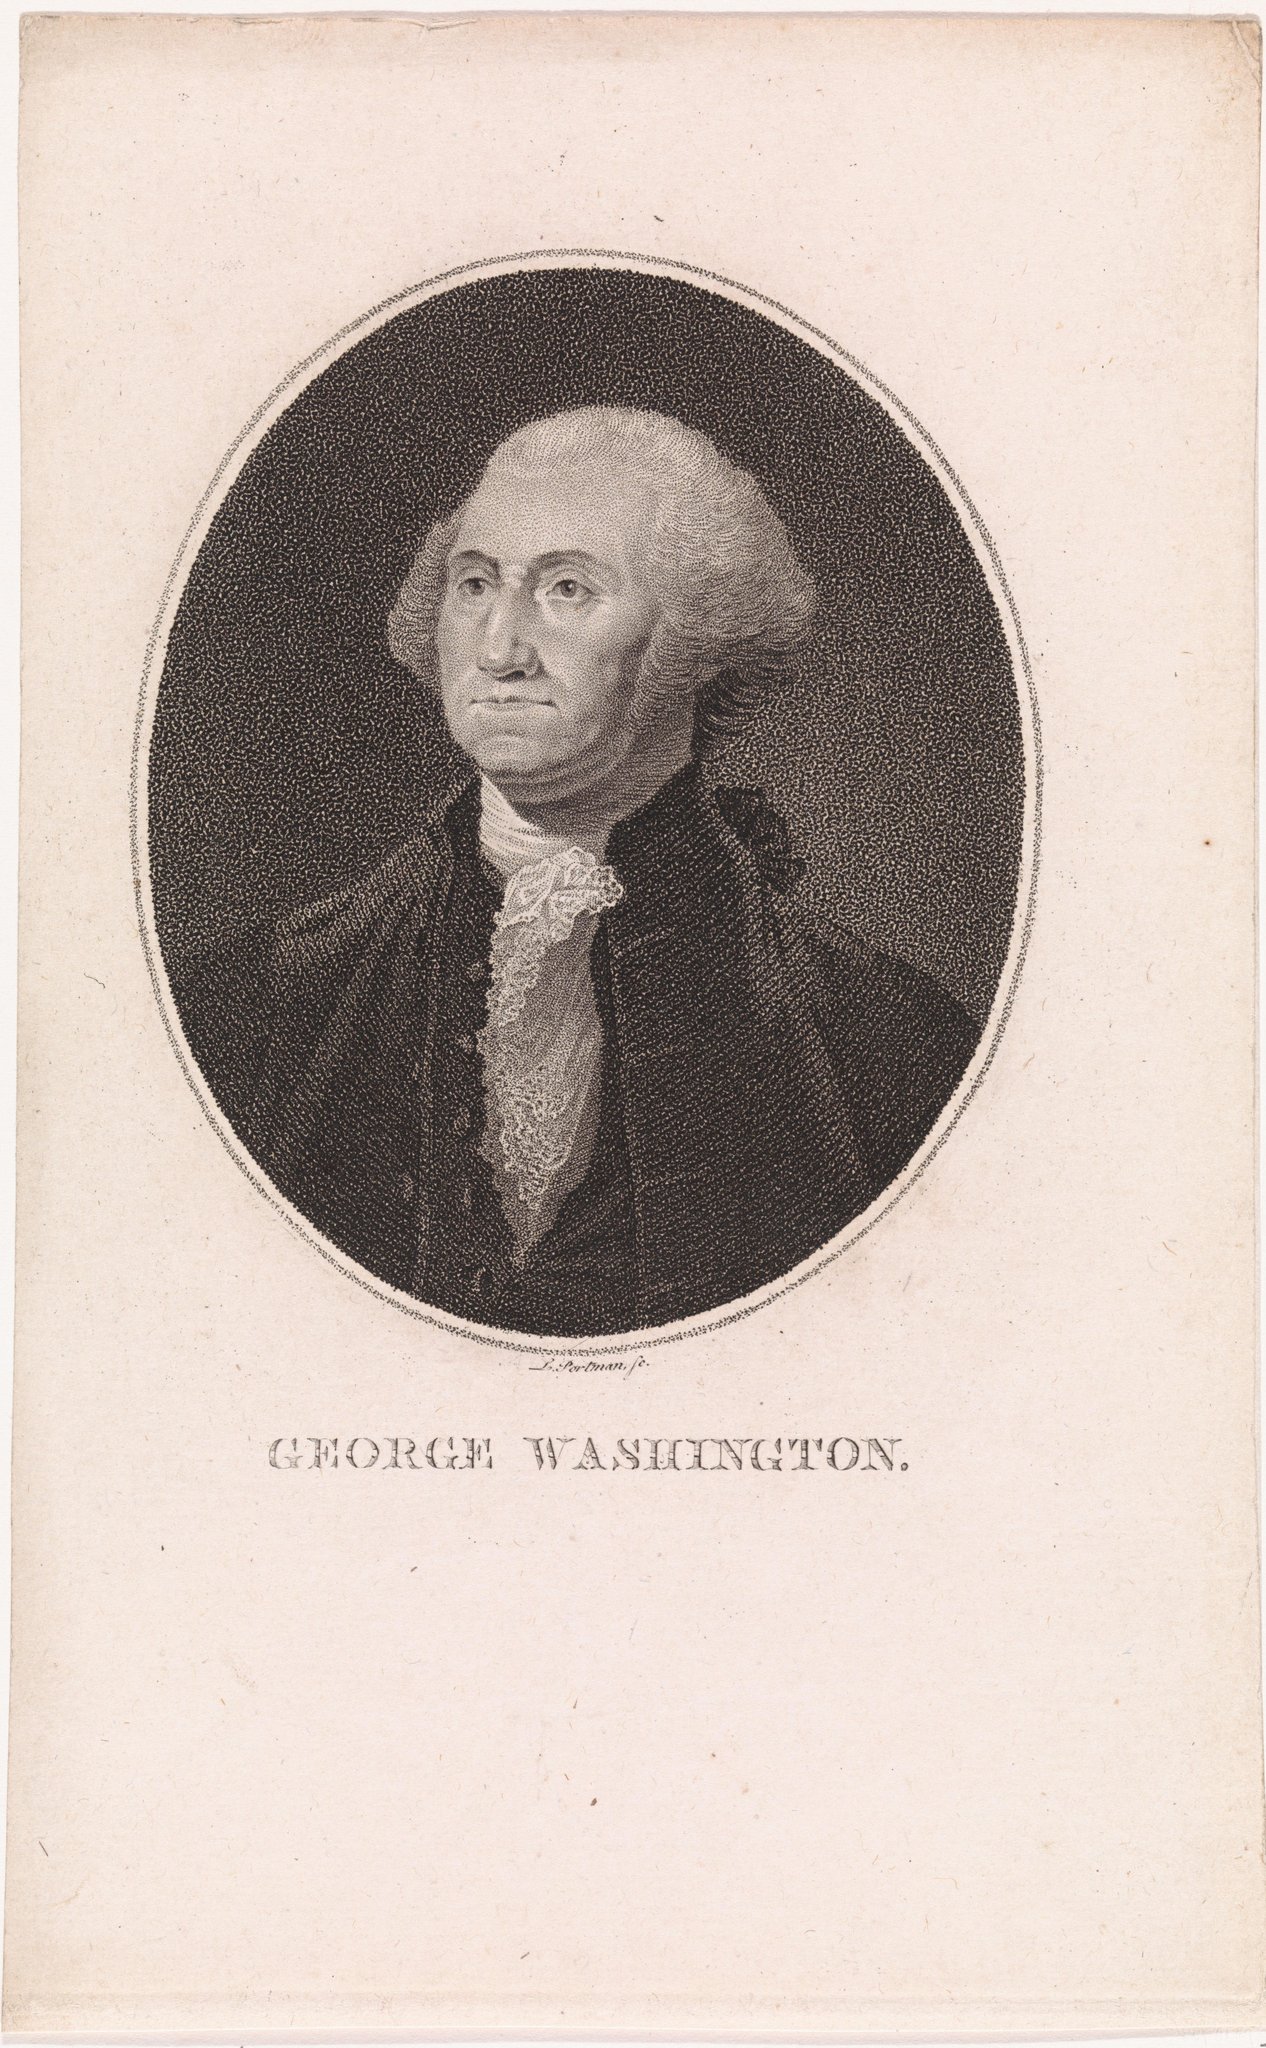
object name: print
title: Portret van George Washington, eerste president van de Verenigde Staten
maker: ludwig gottlieb portman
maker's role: print maker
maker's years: 1772-1828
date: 1805-1828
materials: paper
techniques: etching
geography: amsterdam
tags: virginia, mount vernon, president, george washington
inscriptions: collector's mark: Lugt 2228